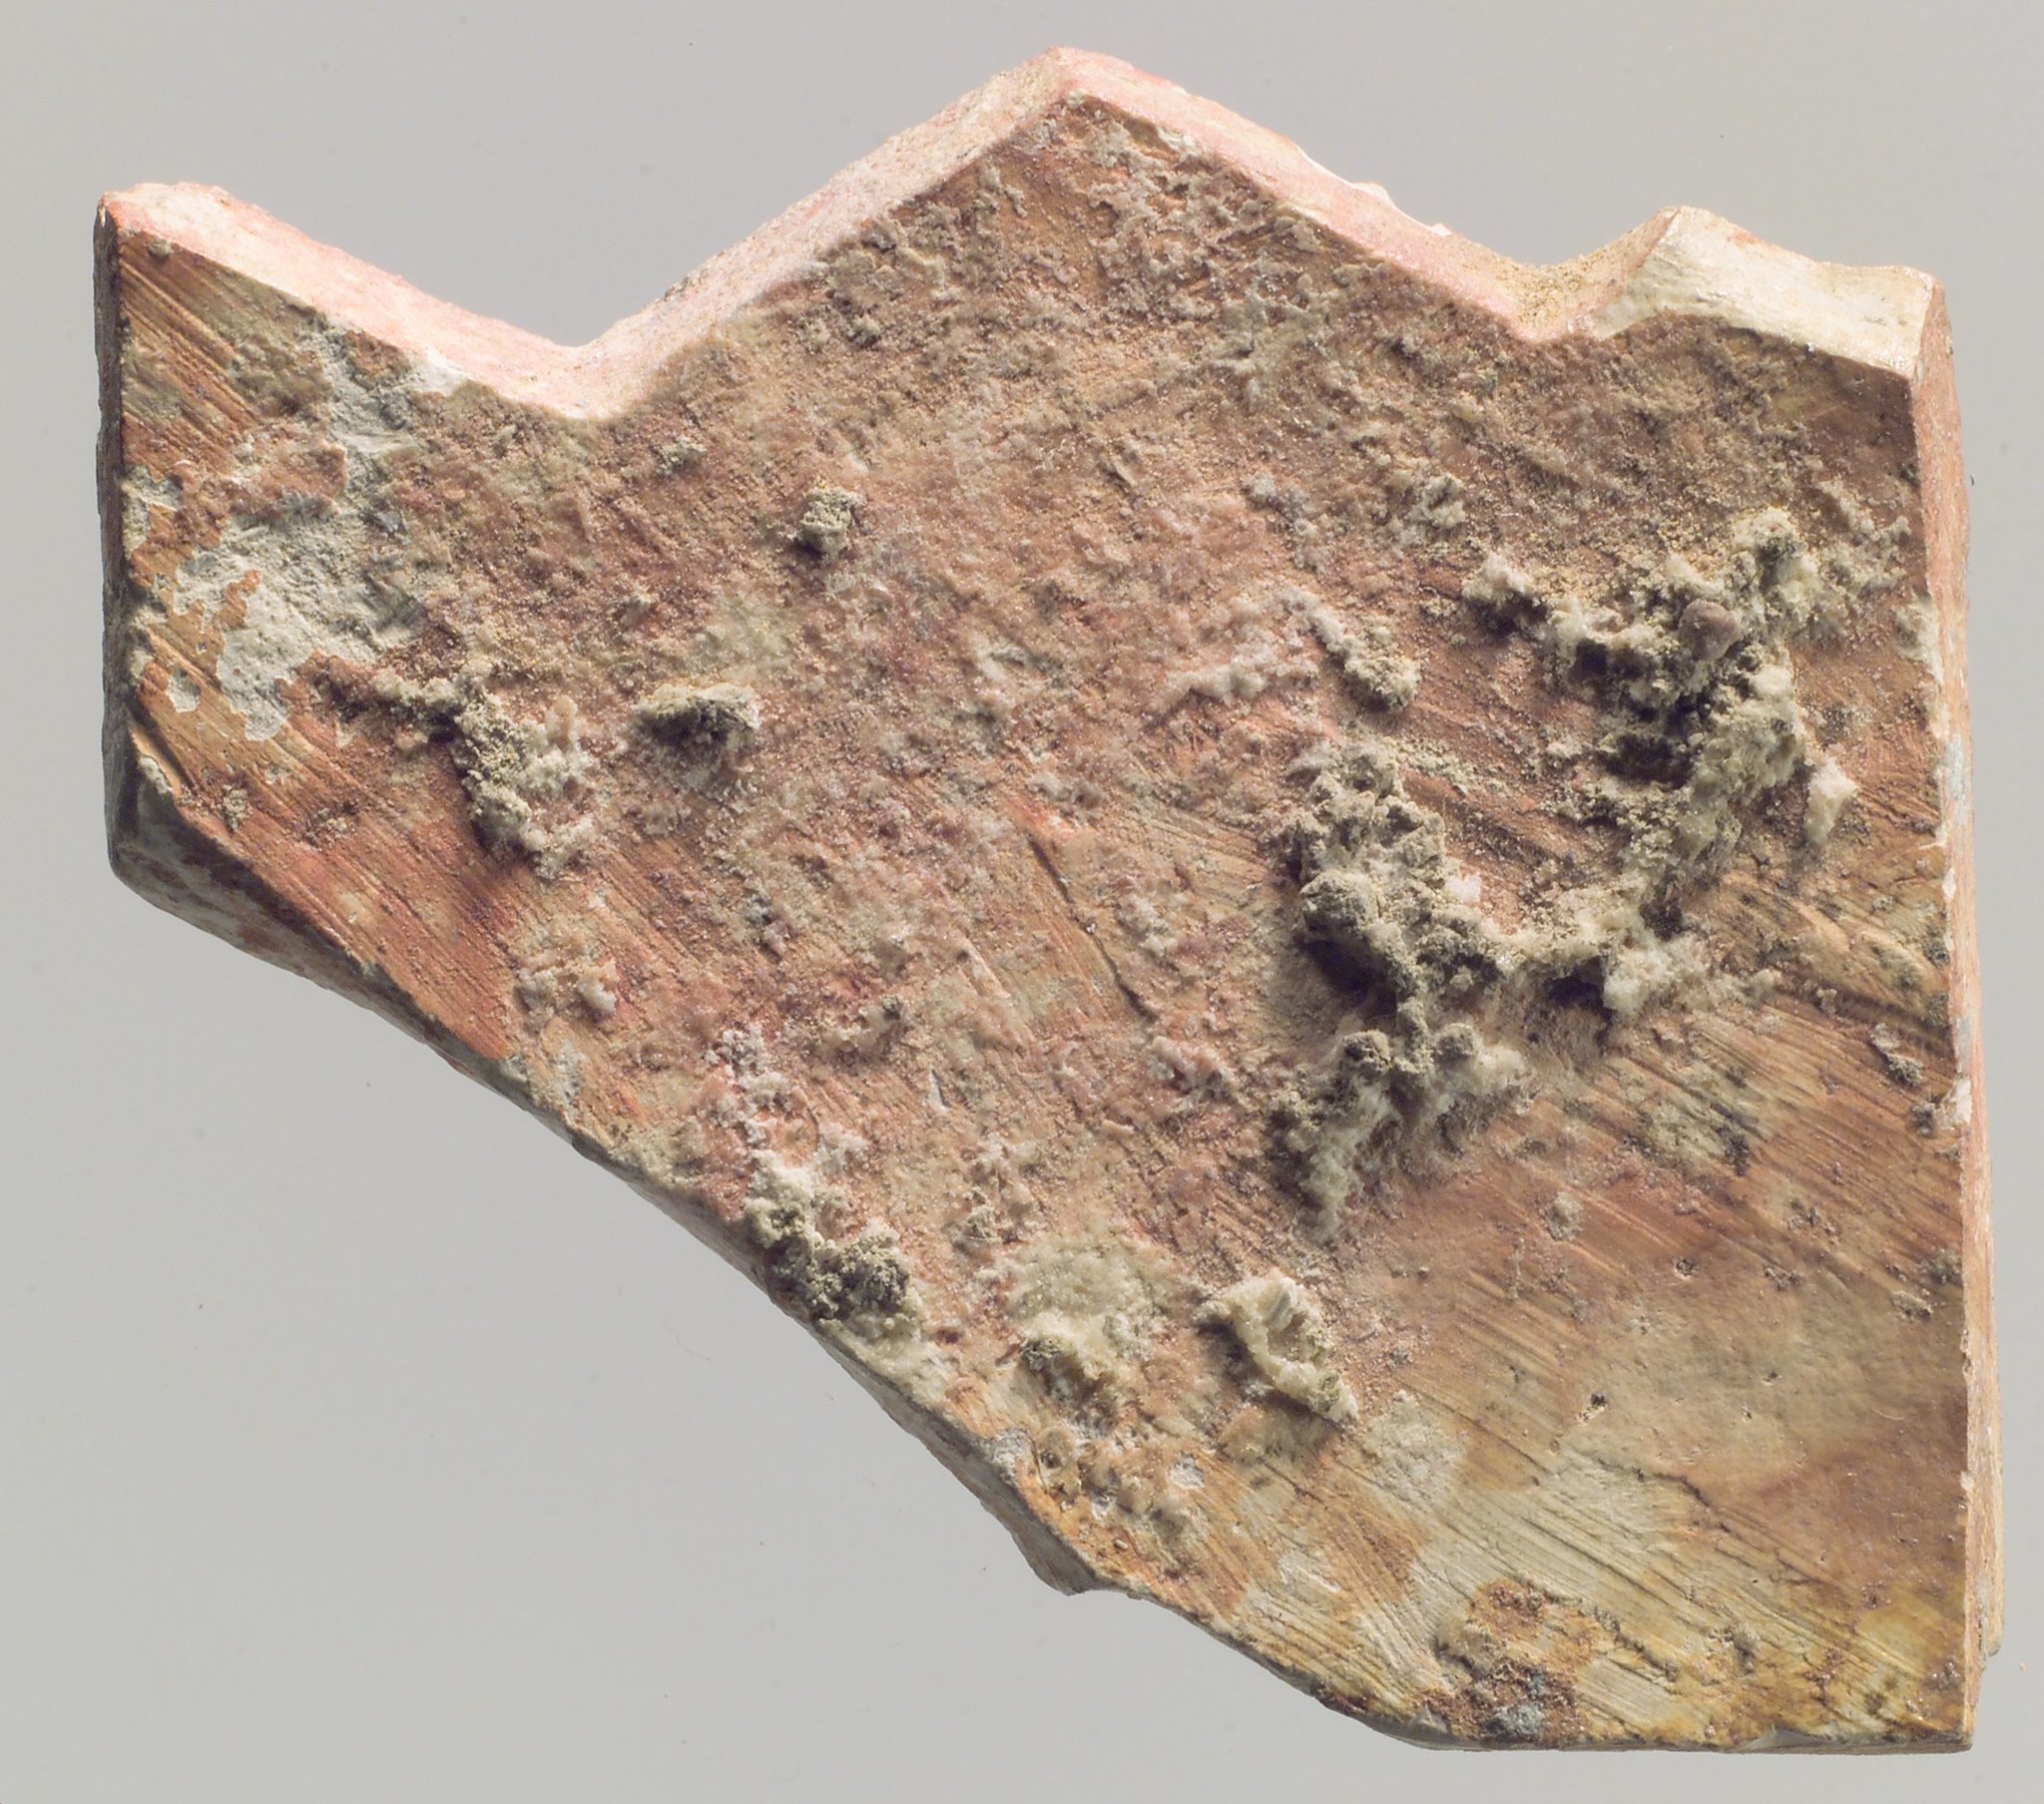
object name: furniture element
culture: assyrian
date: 1800-1701 BCE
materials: ivory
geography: anatolia